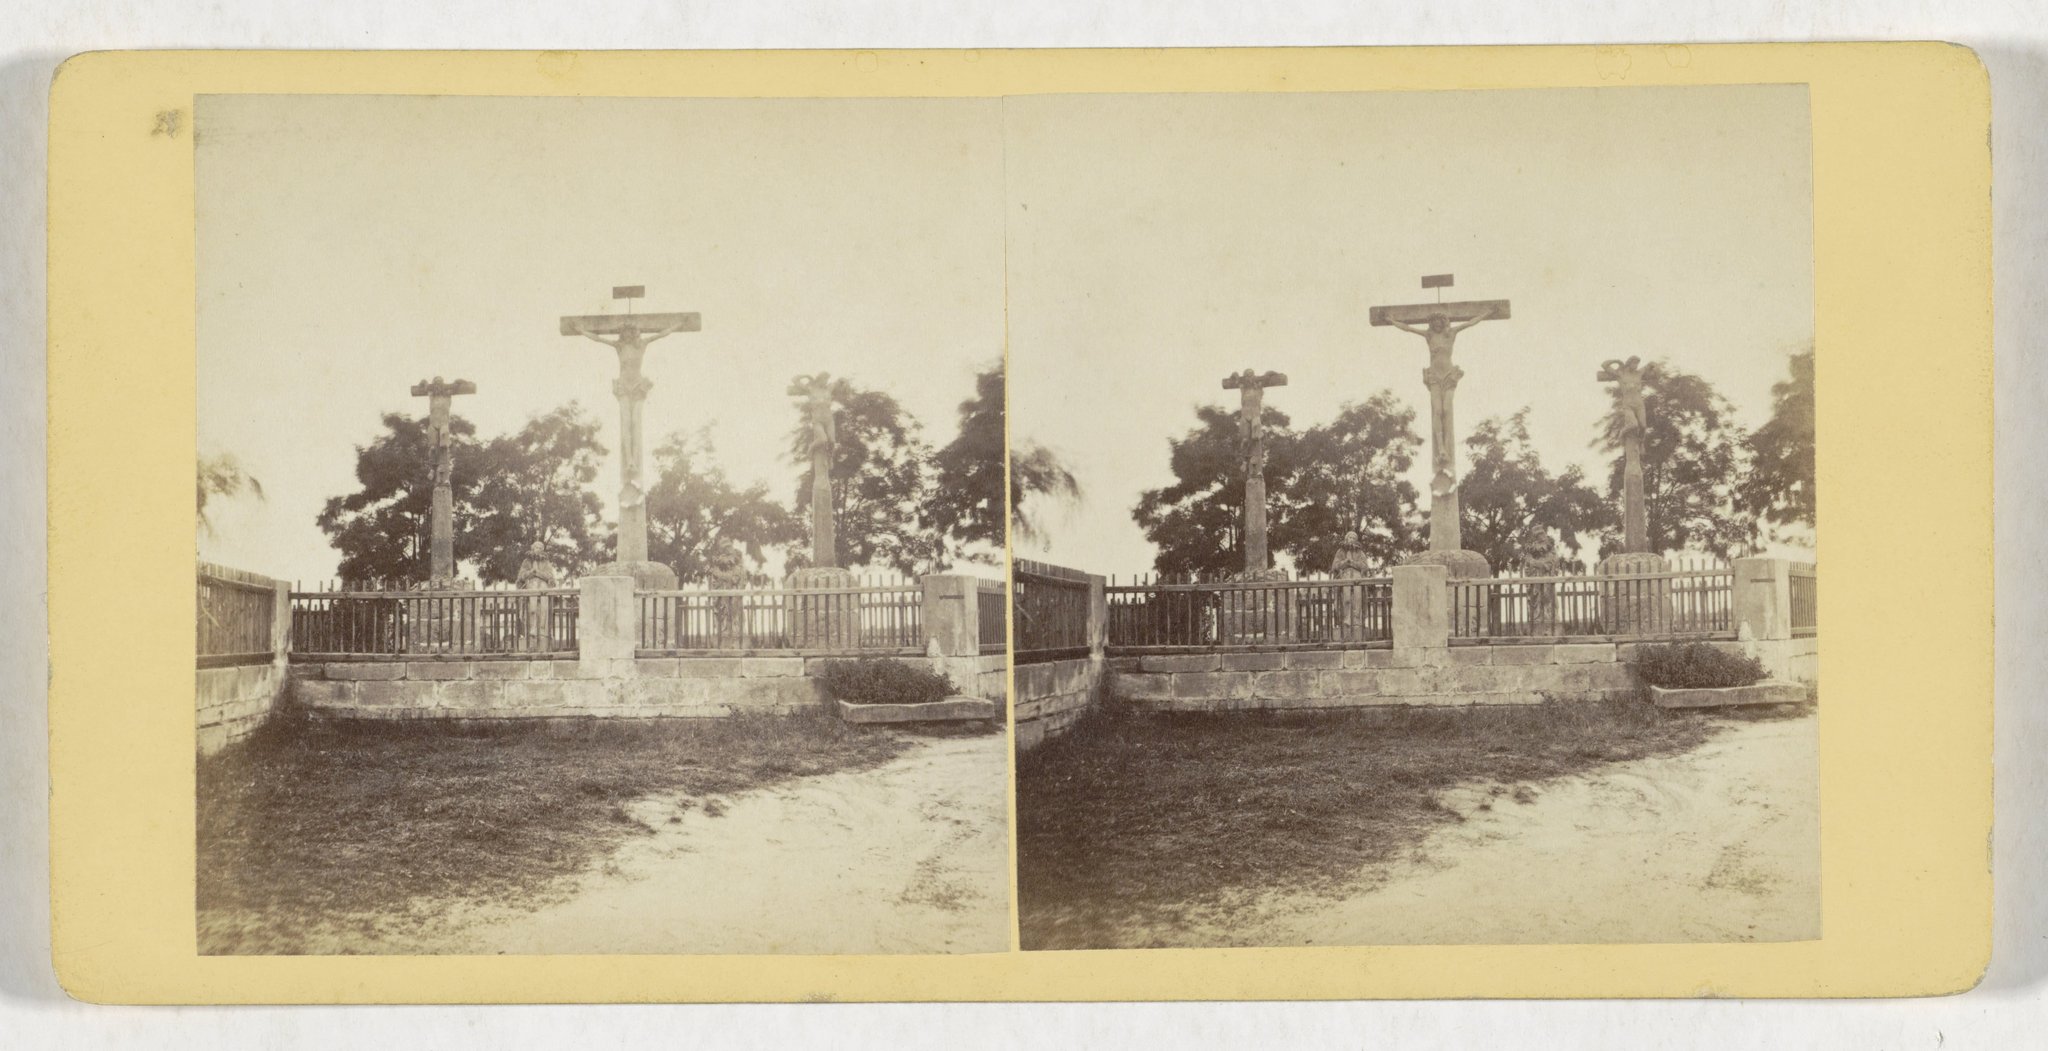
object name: stereograph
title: Die Kreuzigung vor dem Johannes-Kirchhof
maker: johann friedrich stiehm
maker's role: fotograaf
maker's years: 1826-1902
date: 1868-1888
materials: cardboard, paper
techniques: albumen print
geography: nuremberg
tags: crucified christ, with particular persons under the cross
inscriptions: number: ‘No. 30.’